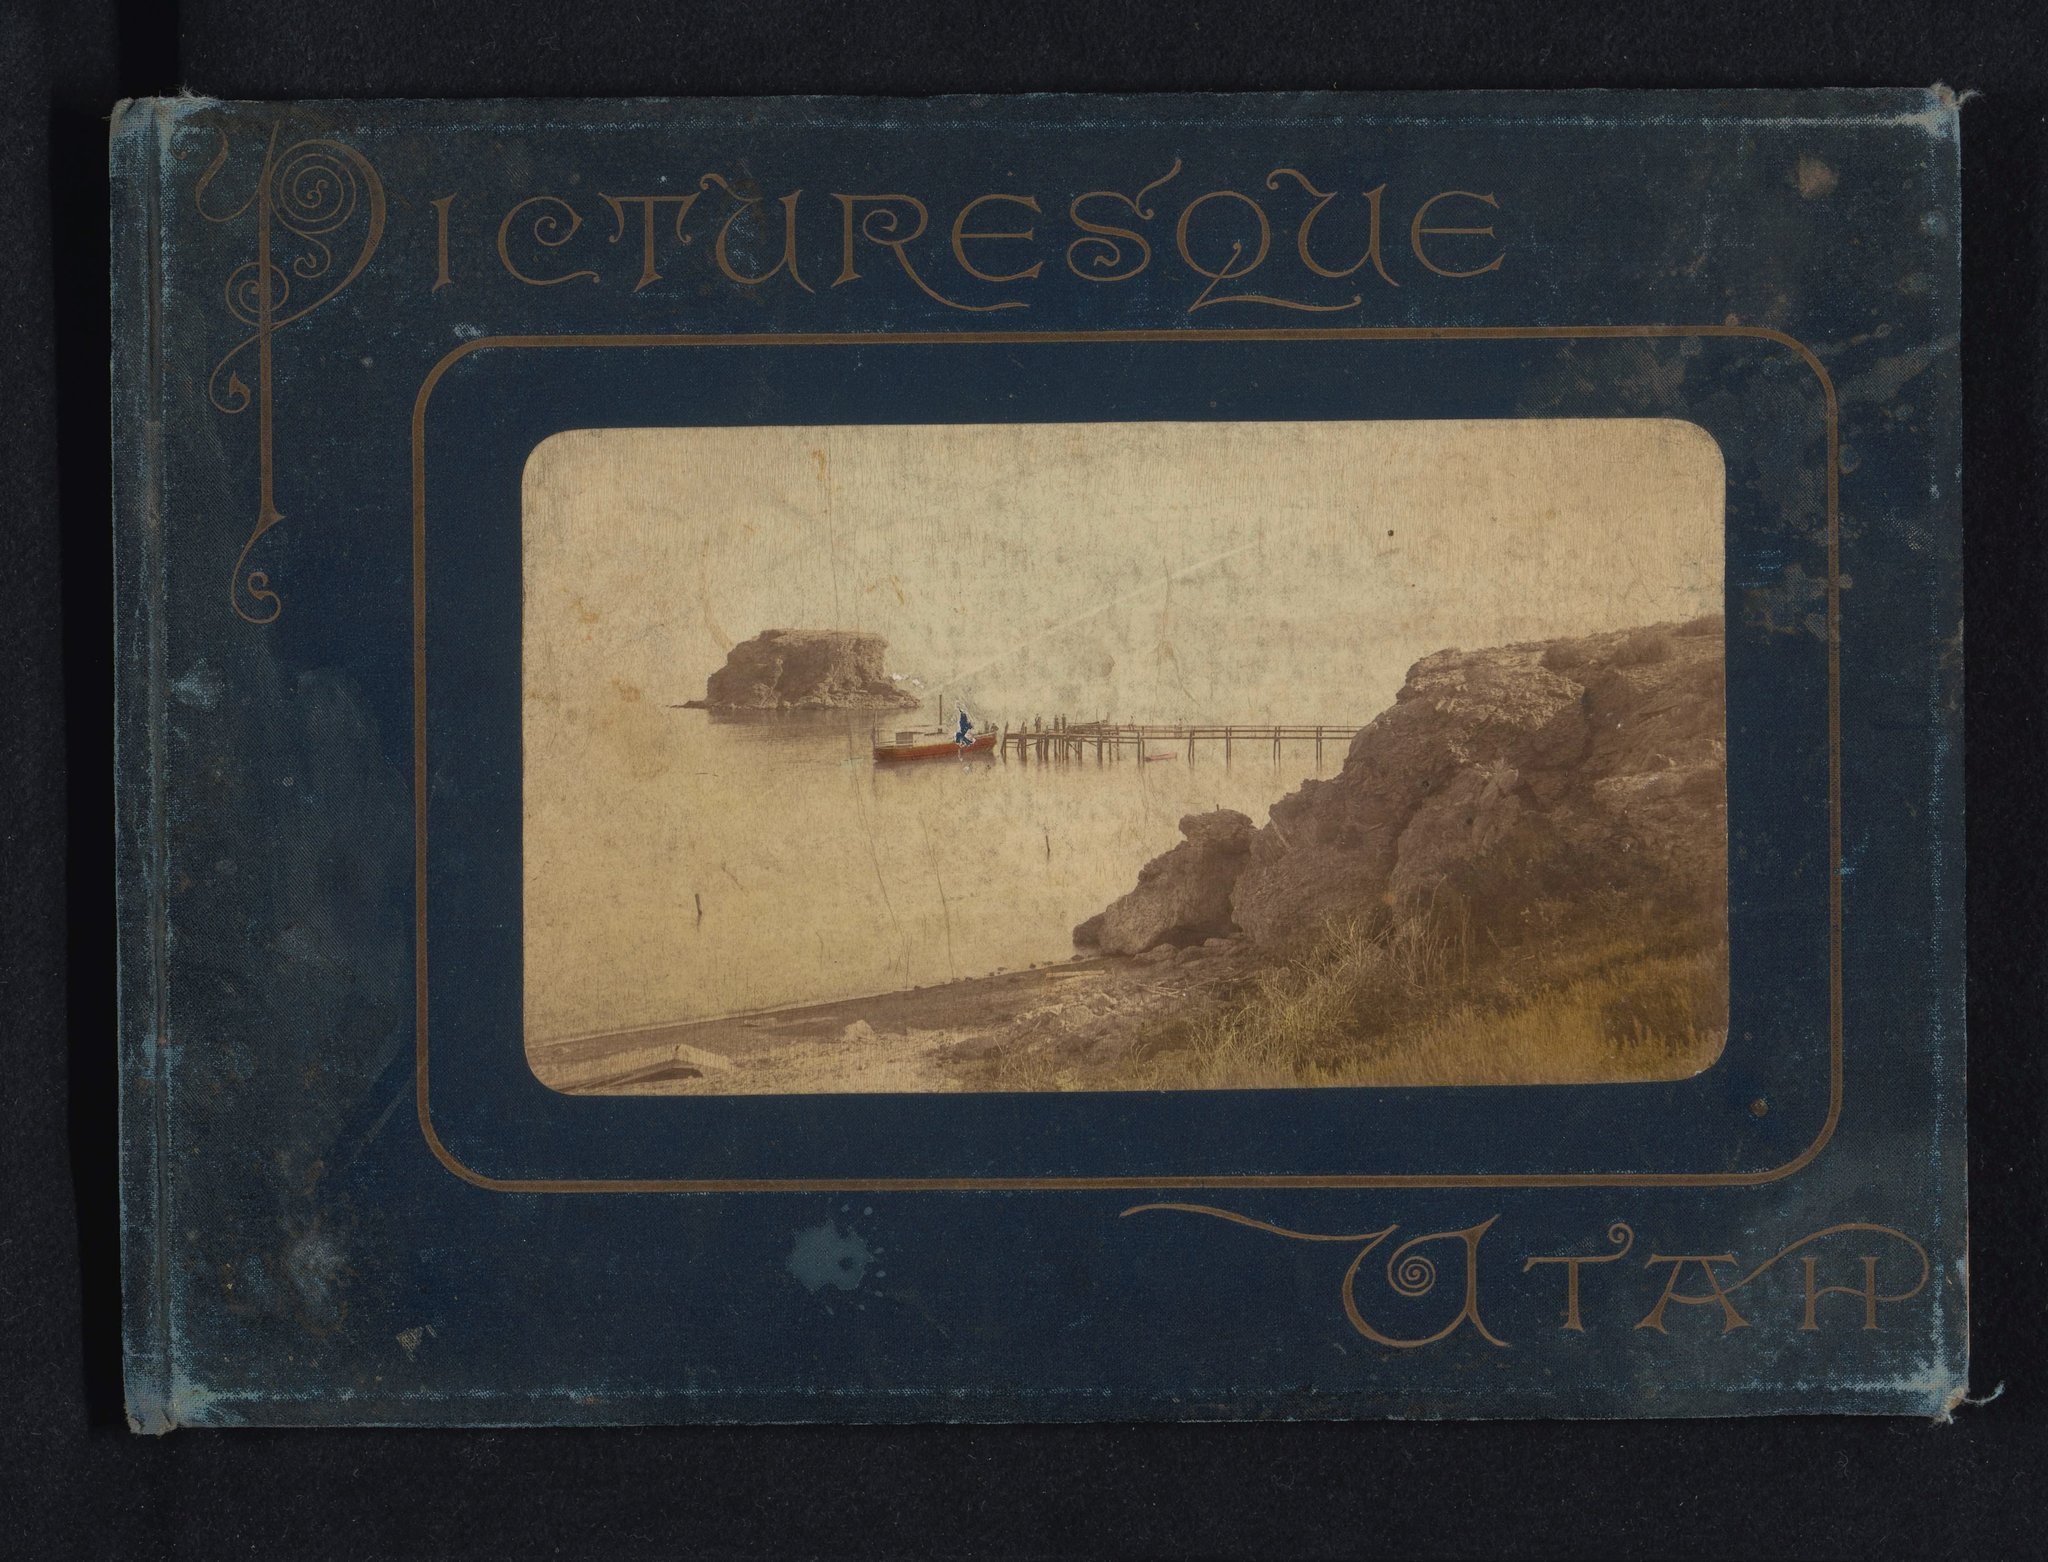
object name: photograph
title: Gezicht op een kleine boot aan een steiger aan een rotsachtige kust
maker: frederick monsen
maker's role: fotograaf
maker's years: 1865-1929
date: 1883-1888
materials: photographic support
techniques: albumen print, hand coloring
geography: denver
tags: rocky coast, rowing-boat, canoe, etc.